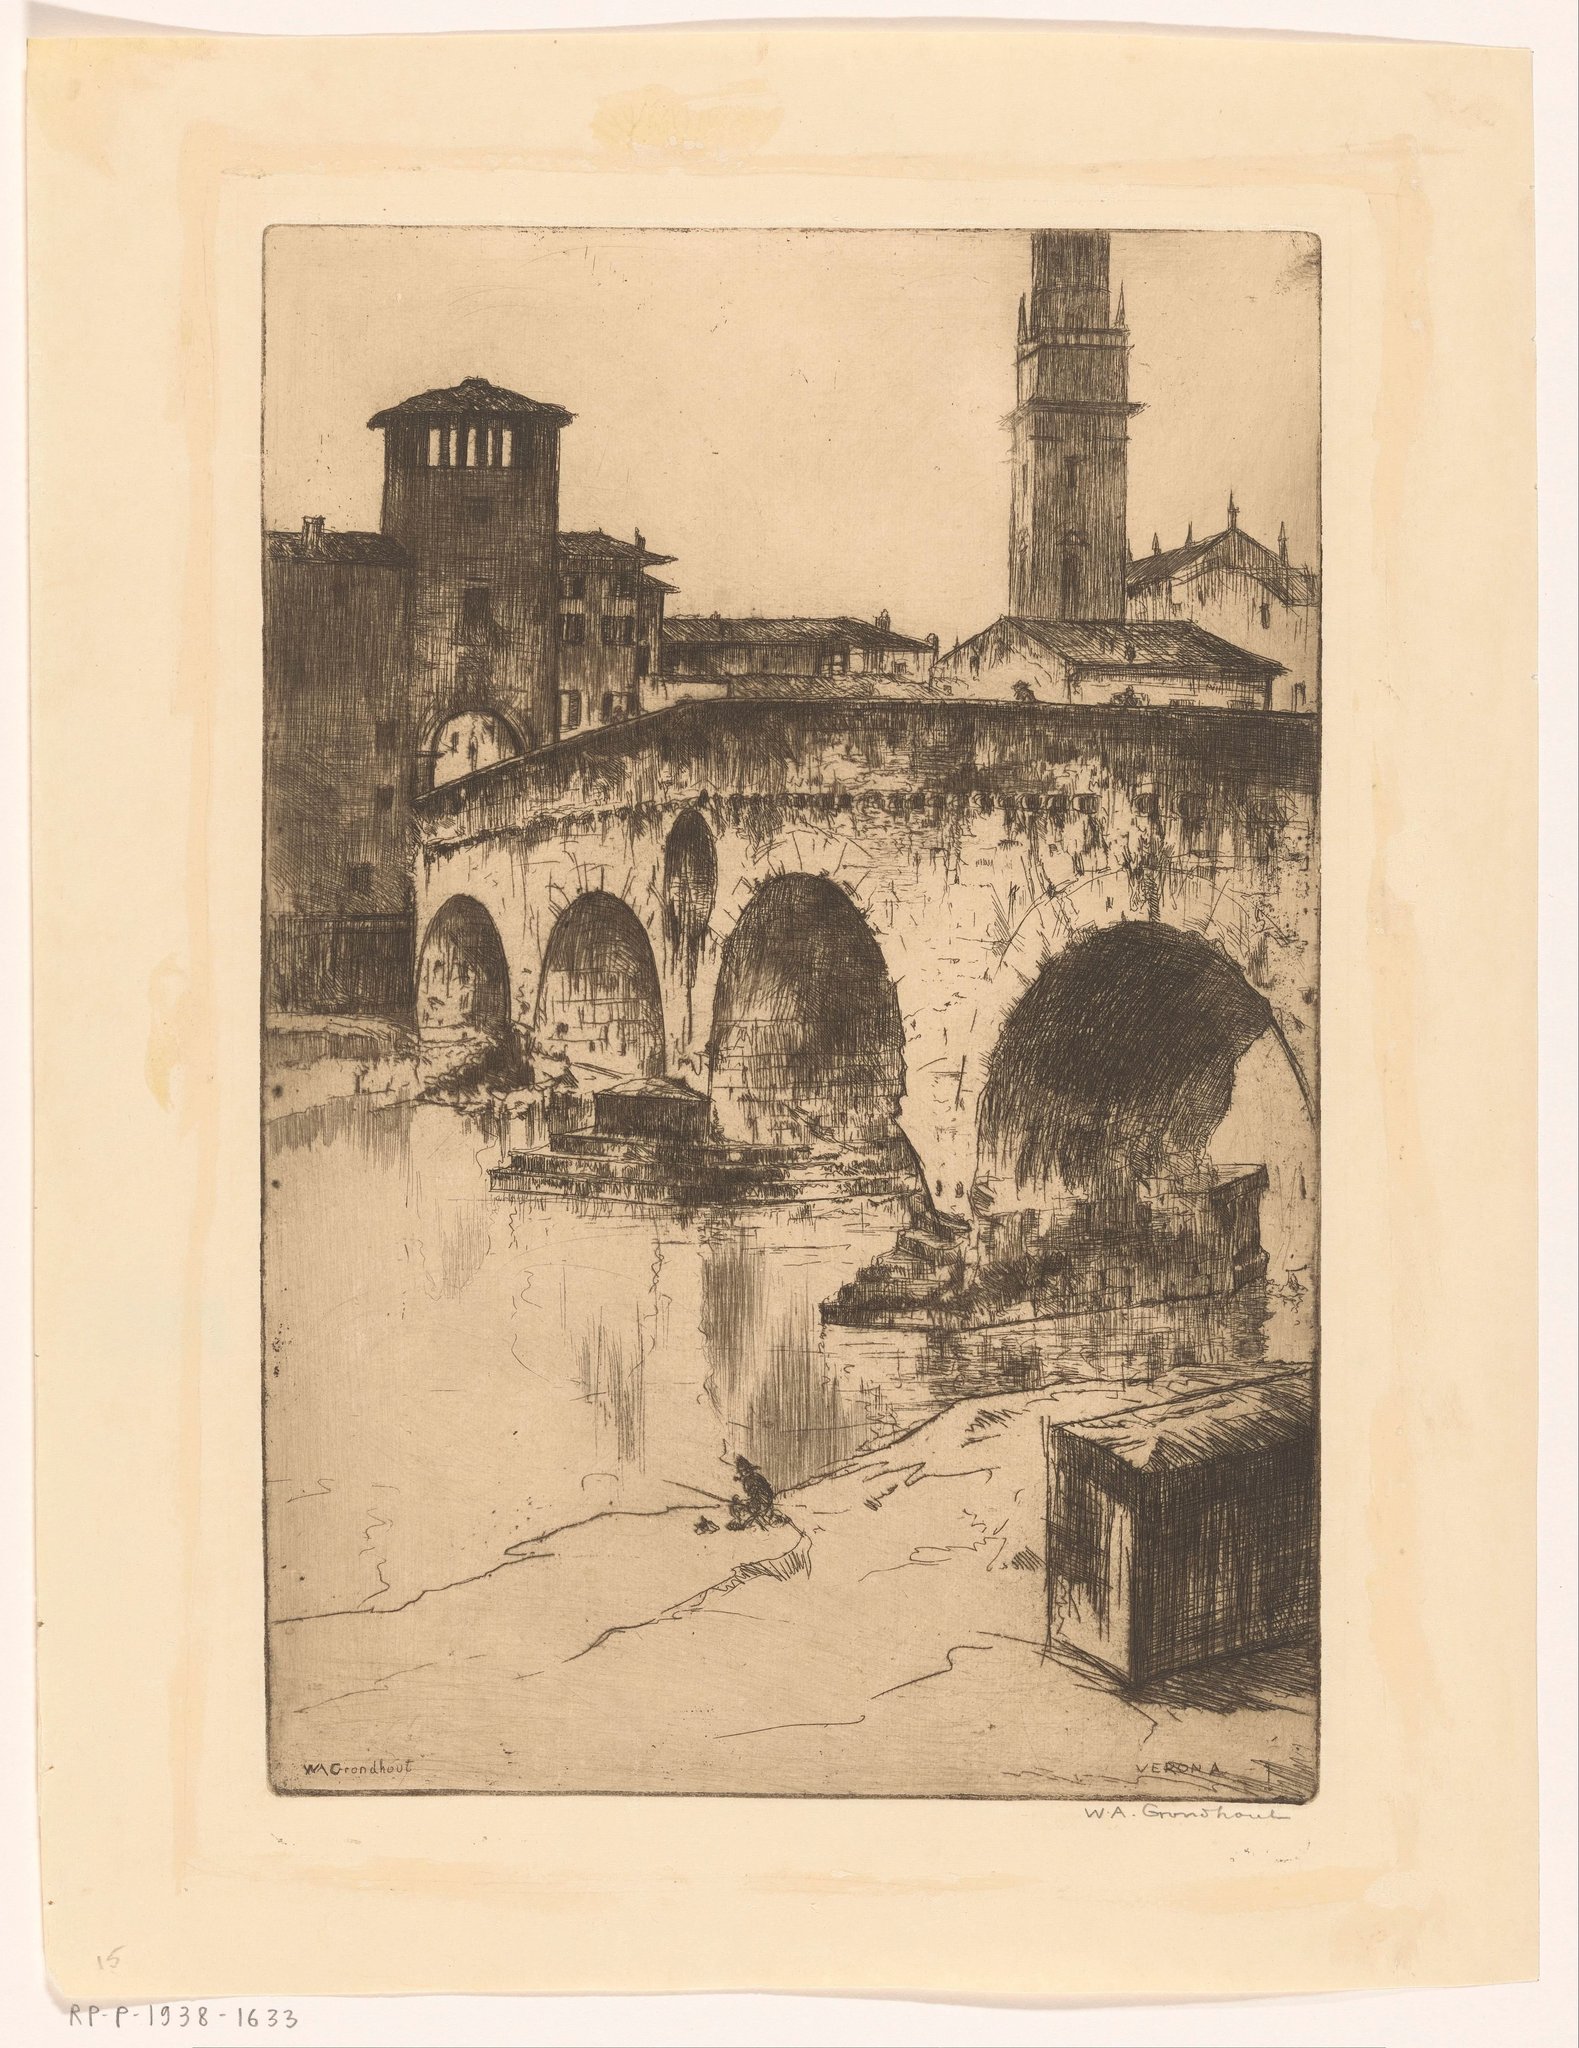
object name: print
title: Verona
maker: willem adrianus grondhout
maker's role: draughtsman, painter, print maker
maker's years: 1878-1934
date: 1888-1934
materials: paper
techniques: etching, intaglio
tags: bridge in city across river, canal, etc.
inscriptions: collector's mark: Lugt 2228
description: De Ponte Pietra over de rivier de Adige in Verona.